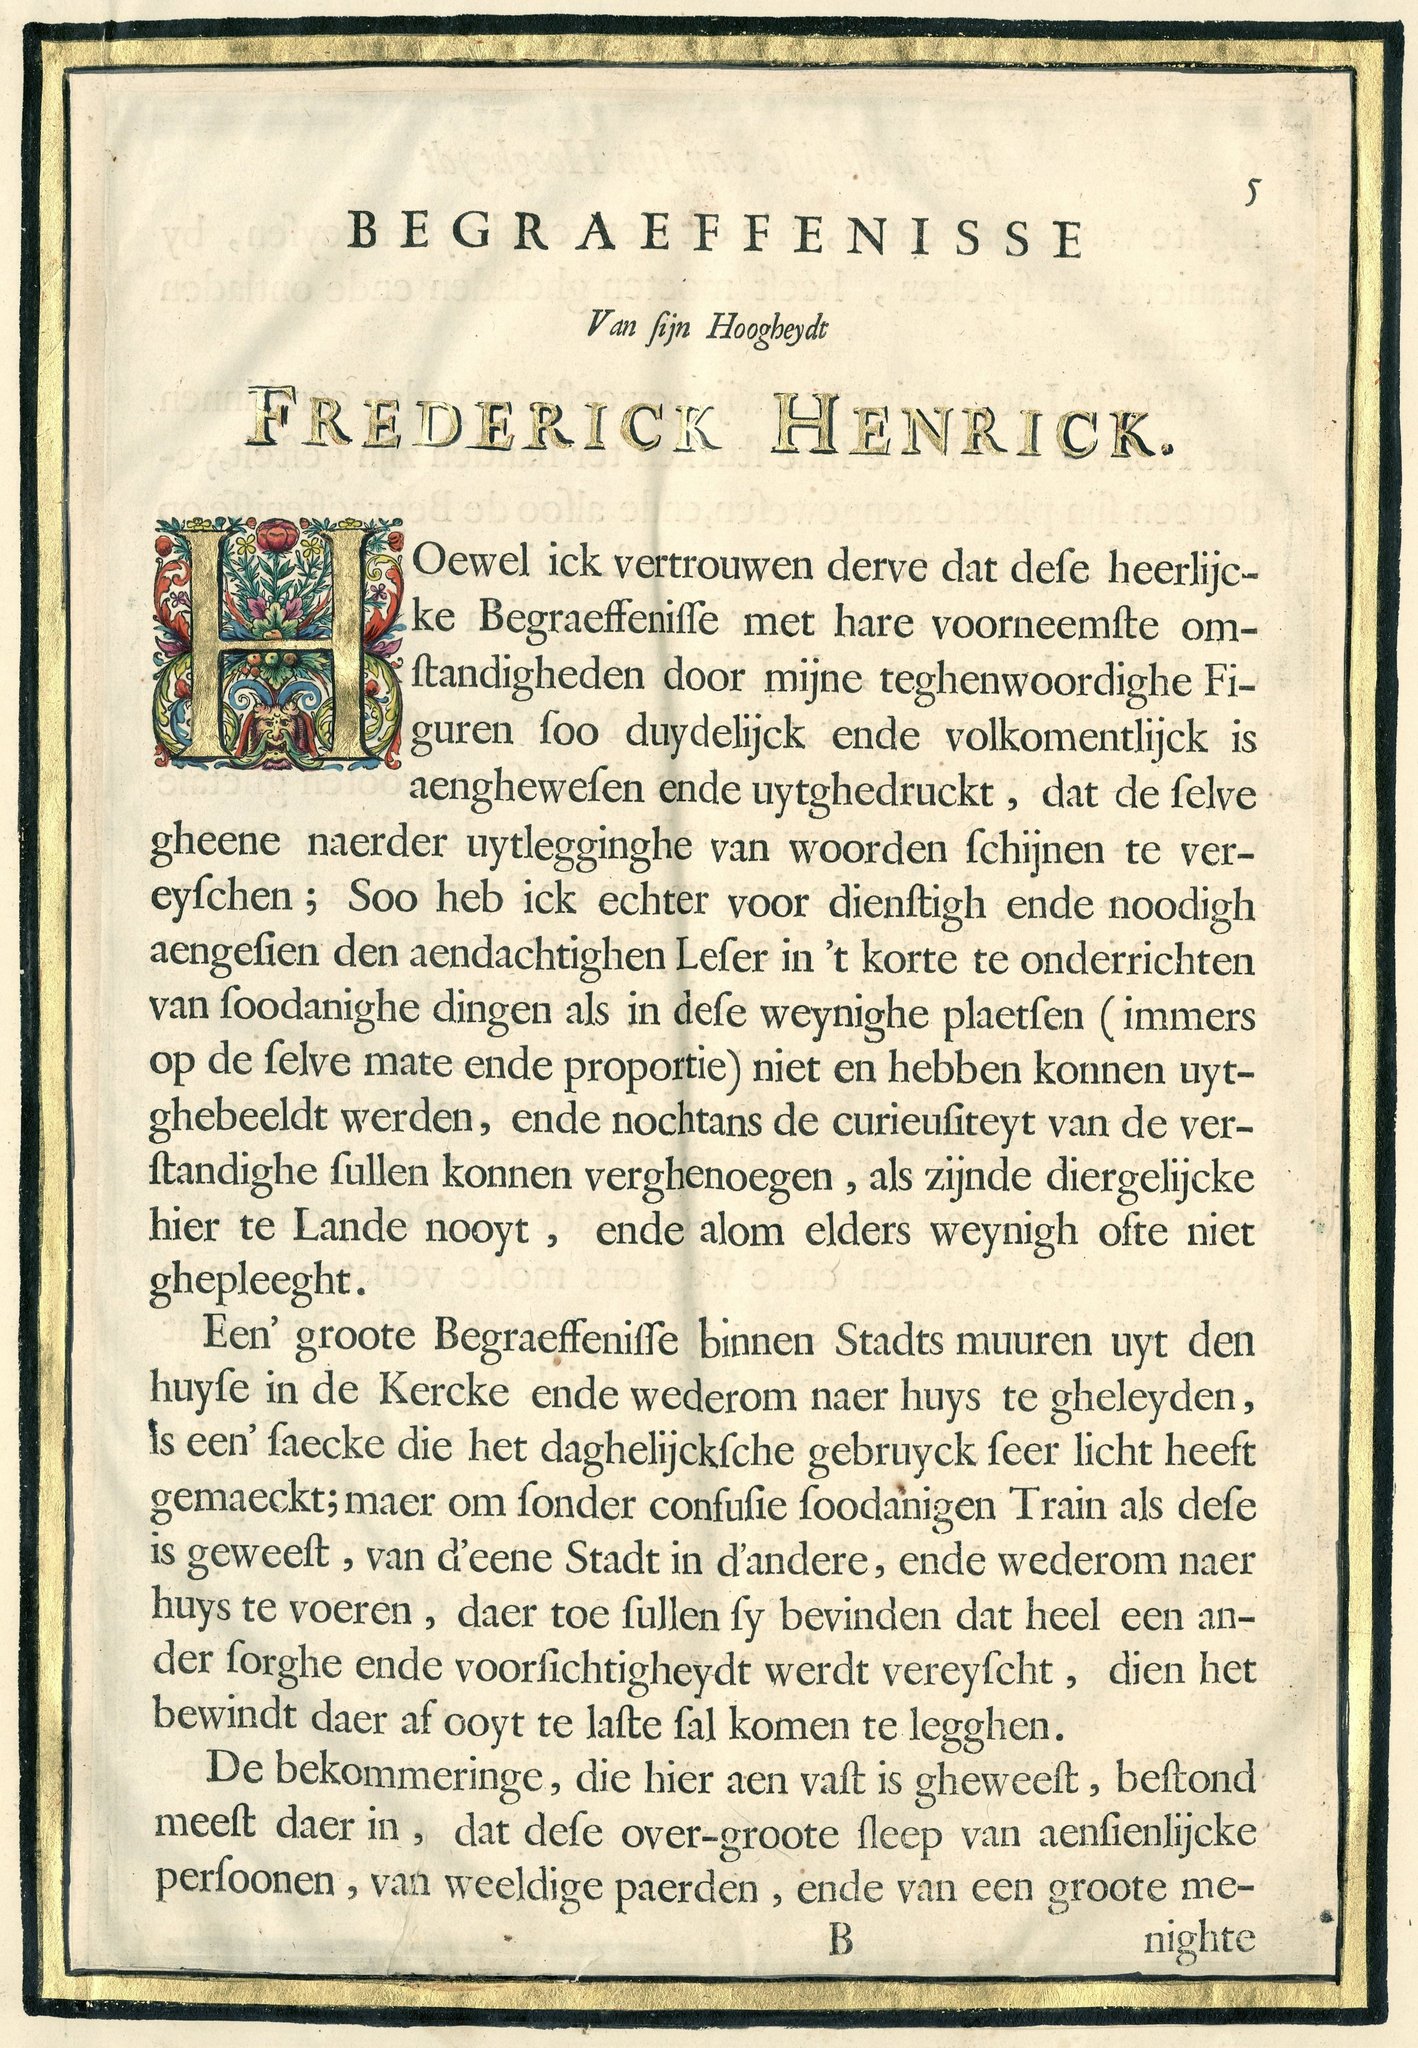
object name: text sheet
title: De beschrijving van de begrafenis van Frederik Hendrik, p. 05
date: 1651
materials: paint, paper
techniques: colour, letterpress printing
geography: amsterdam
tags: delft, the hague, frederick henry (prince of orange)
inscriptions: date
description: Pagina 5 van de beschrijving van de begrafenis van Frederik Hendrik. Met versierde initiaal H. Blad uitgeknipt, versierd met goud en ingeplakt in de luxe editie uit ca. 1755 van het boek 'Begraeffenisse van syne hoogheyt Frederick Henrick' van Pieter Post, uitgegeven te Amsterdam in 1651.